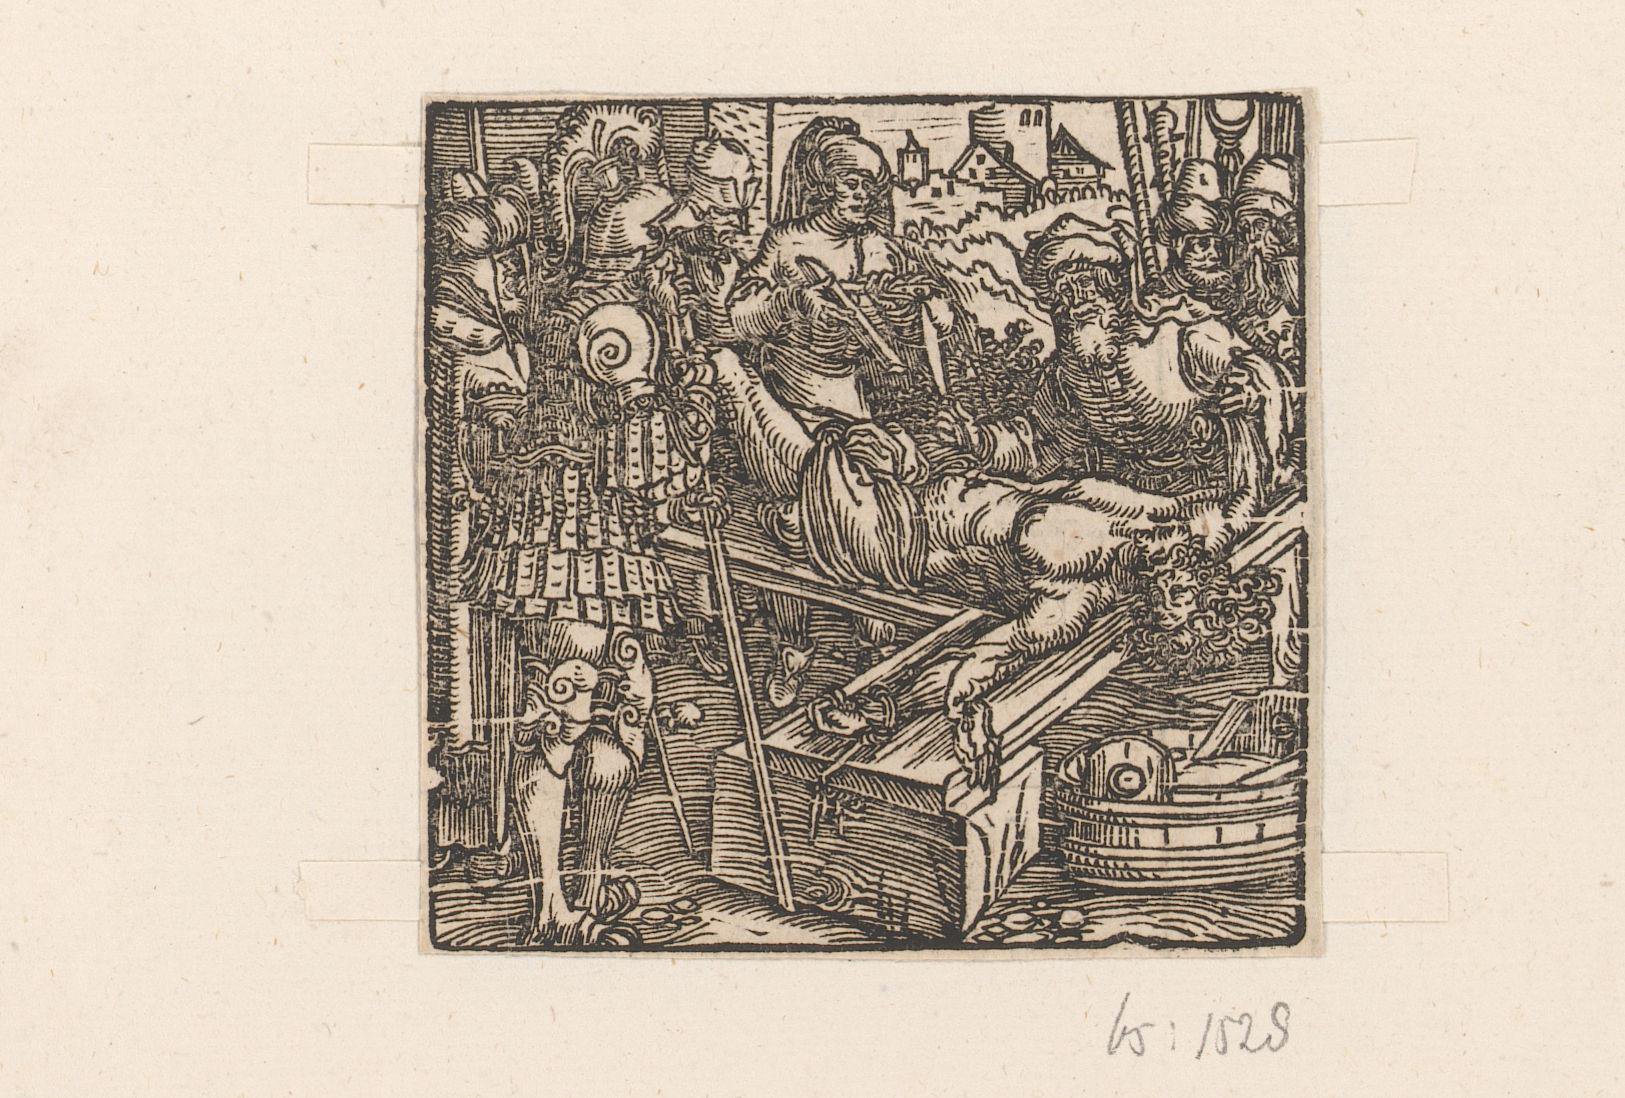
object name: album leaf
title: Martelaarschap van Filippus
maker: Anonymous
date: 1500-1536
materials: paper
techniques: woodcut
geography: germany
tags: the apostle philip; possible attributes: book, cross, dish with snake, lance, scroll, stone, sword - martyrdom, suffering, misfortune, death of male saint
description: Filippus wordt gekruisigd. Prent maakt deel uit van een album.